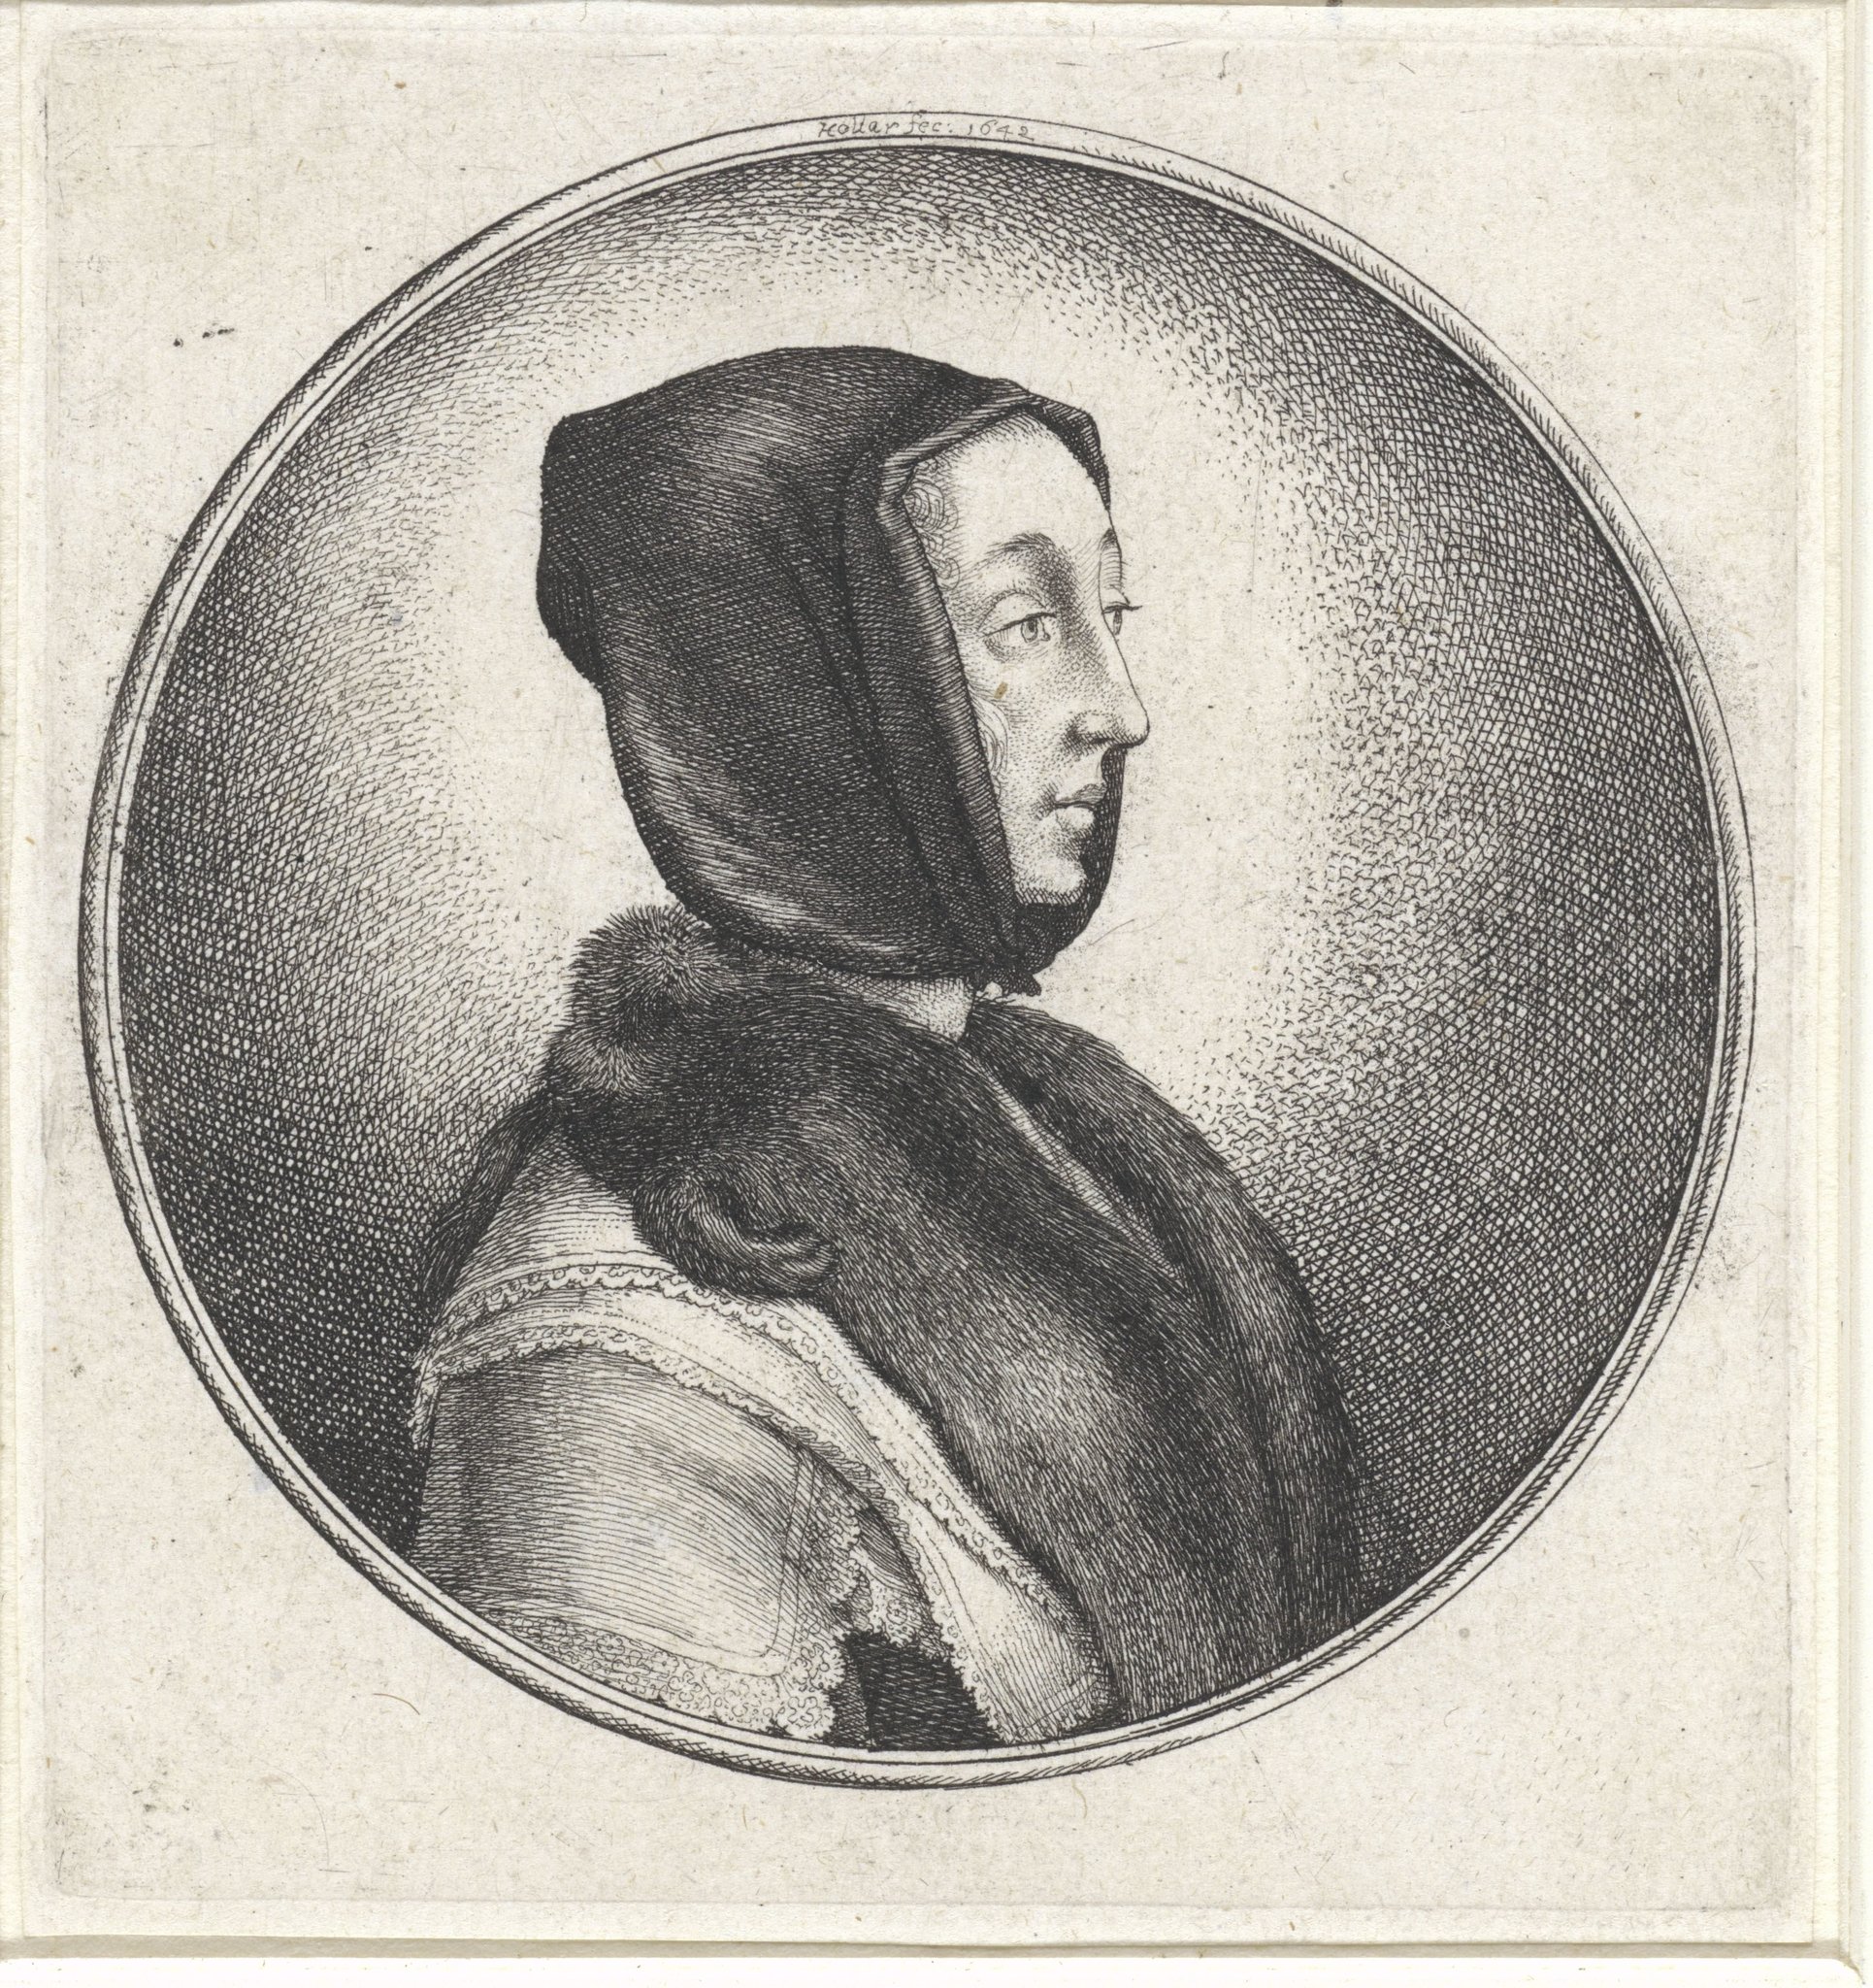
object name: print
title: Vrouw met zwarte hoofddoek en stola van bont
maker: wenceslaus hollar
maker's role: draughtsman, print maker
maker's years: 1607-1677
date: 1642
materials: paper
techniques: etching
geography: london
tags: neck-gear ~ clothing (neckerchief) (+ women's clothes), head-gear: hood (+ women's clothes), clothing for the upper part of the body (stola) (+ fur used for clothes), clothing for the upper part of the body (stola) (+ women's clothes), anonymous historical person portrayed alone - bb - woman, england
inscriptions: collector's mark: Lugt 654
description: De prent maakt deel uit van een 13-delige serie met vrouwenbusten in medaillons.